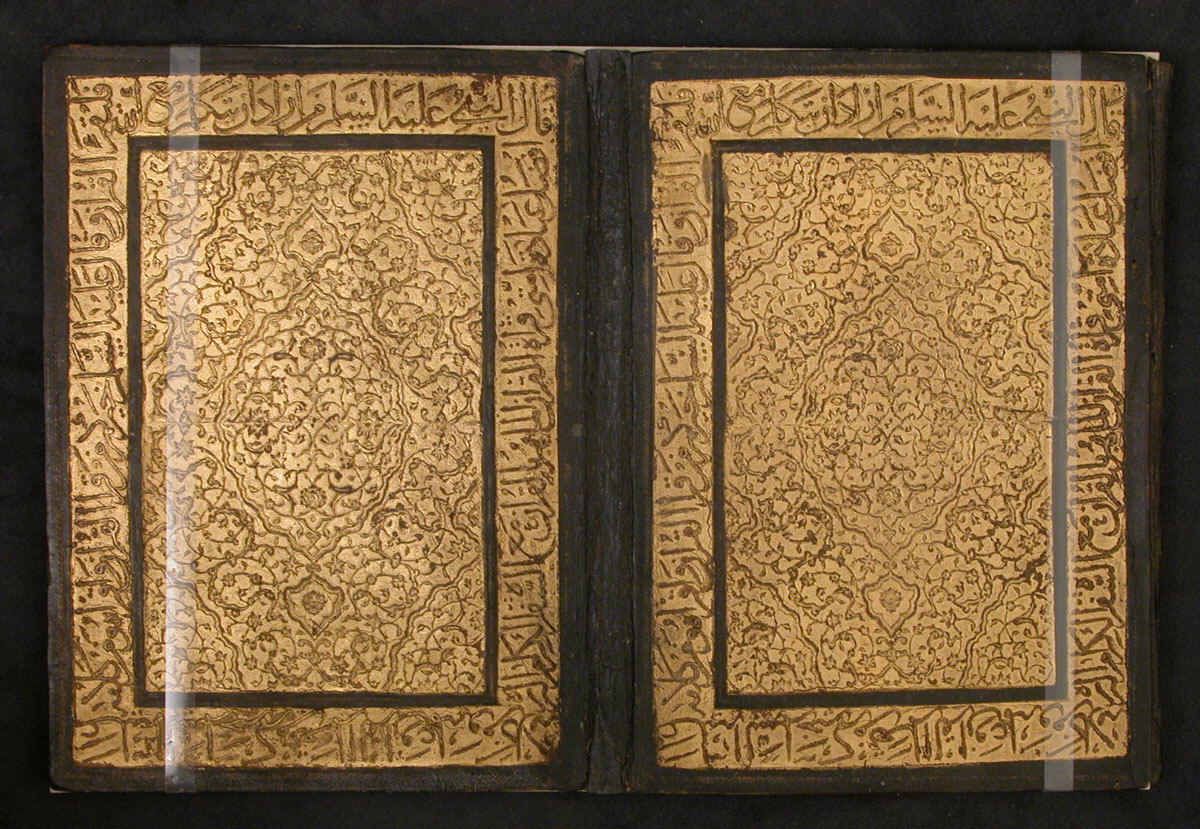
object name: bookbinding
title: Qur'an Bookbinding with Floral Arabesques and an Inscription from the Hadith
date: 1601-1633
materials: leather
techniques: gilding, stamping, tooling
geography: iran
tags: arabic